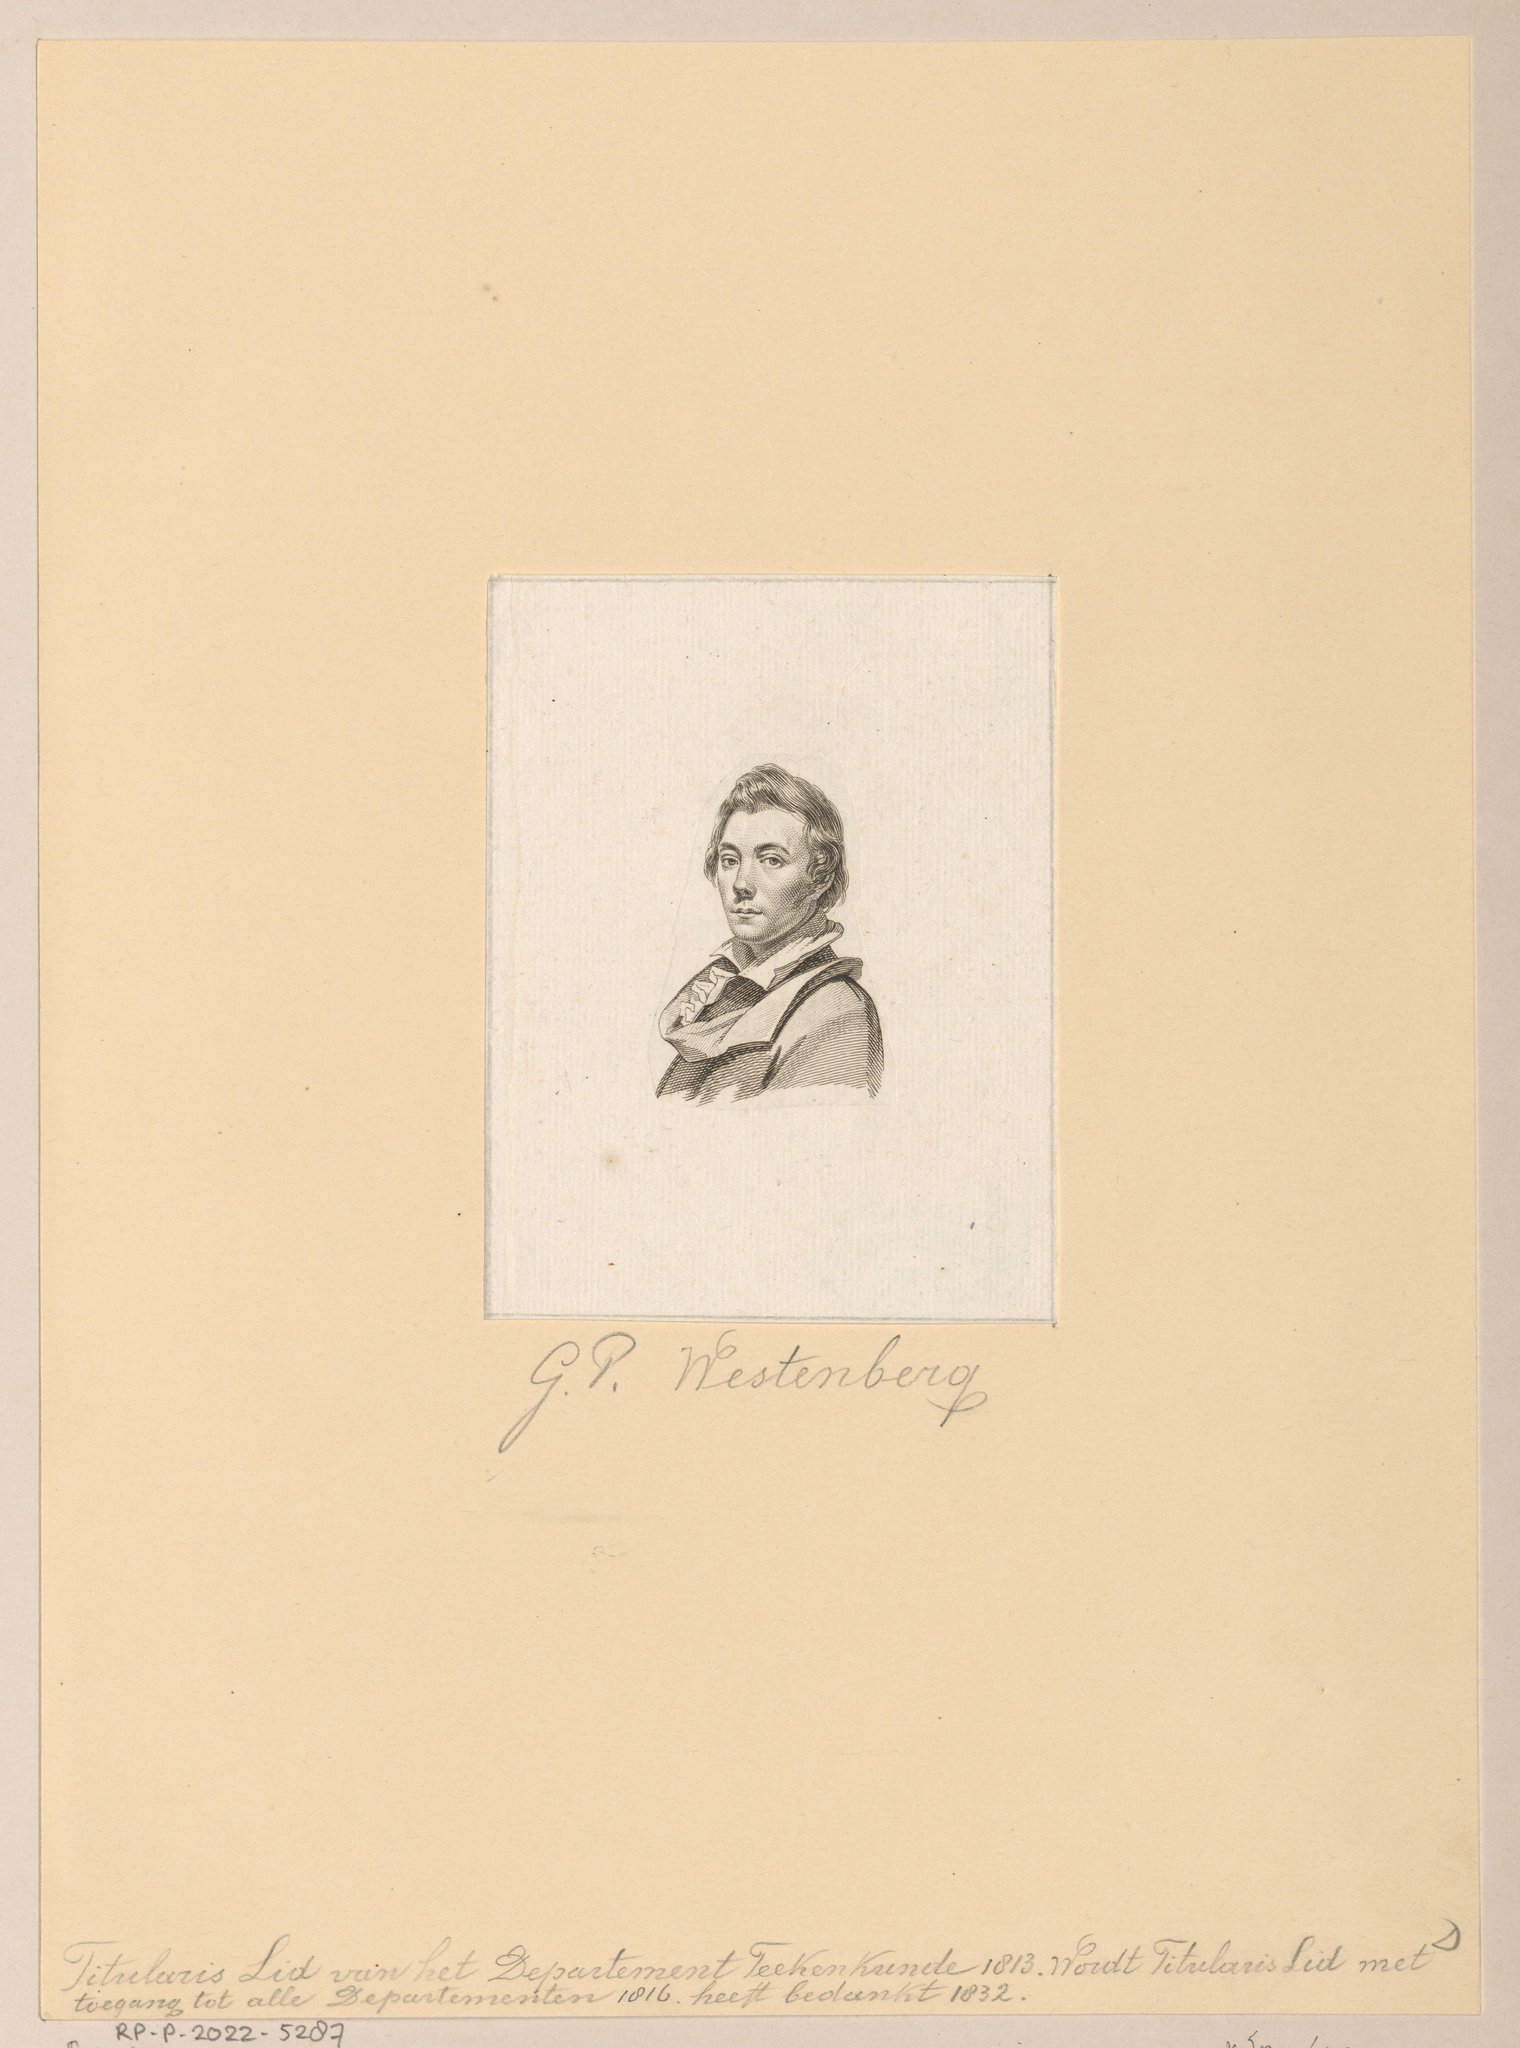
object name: print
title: Portret van George Pieter Westenberg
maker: pieter van der meulen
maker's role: draughtsman, painter, print maker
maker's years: 1780-1858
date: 1820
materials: paper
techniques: etching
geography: amsterdam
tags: nijmegen, george pieter westenberg, historical persons, portrait, self-portrait of painter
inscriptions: collector's mark: Lugt 924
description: Prent waarschijnlijk uit: Eynden, Roeland van, en Adriaan van der Willigen. Geschiedenis der vaderlandsche schilderkunst sedert de helft der XVIII eeuw. Haarlem: Adriaan Loosjes, 1820.